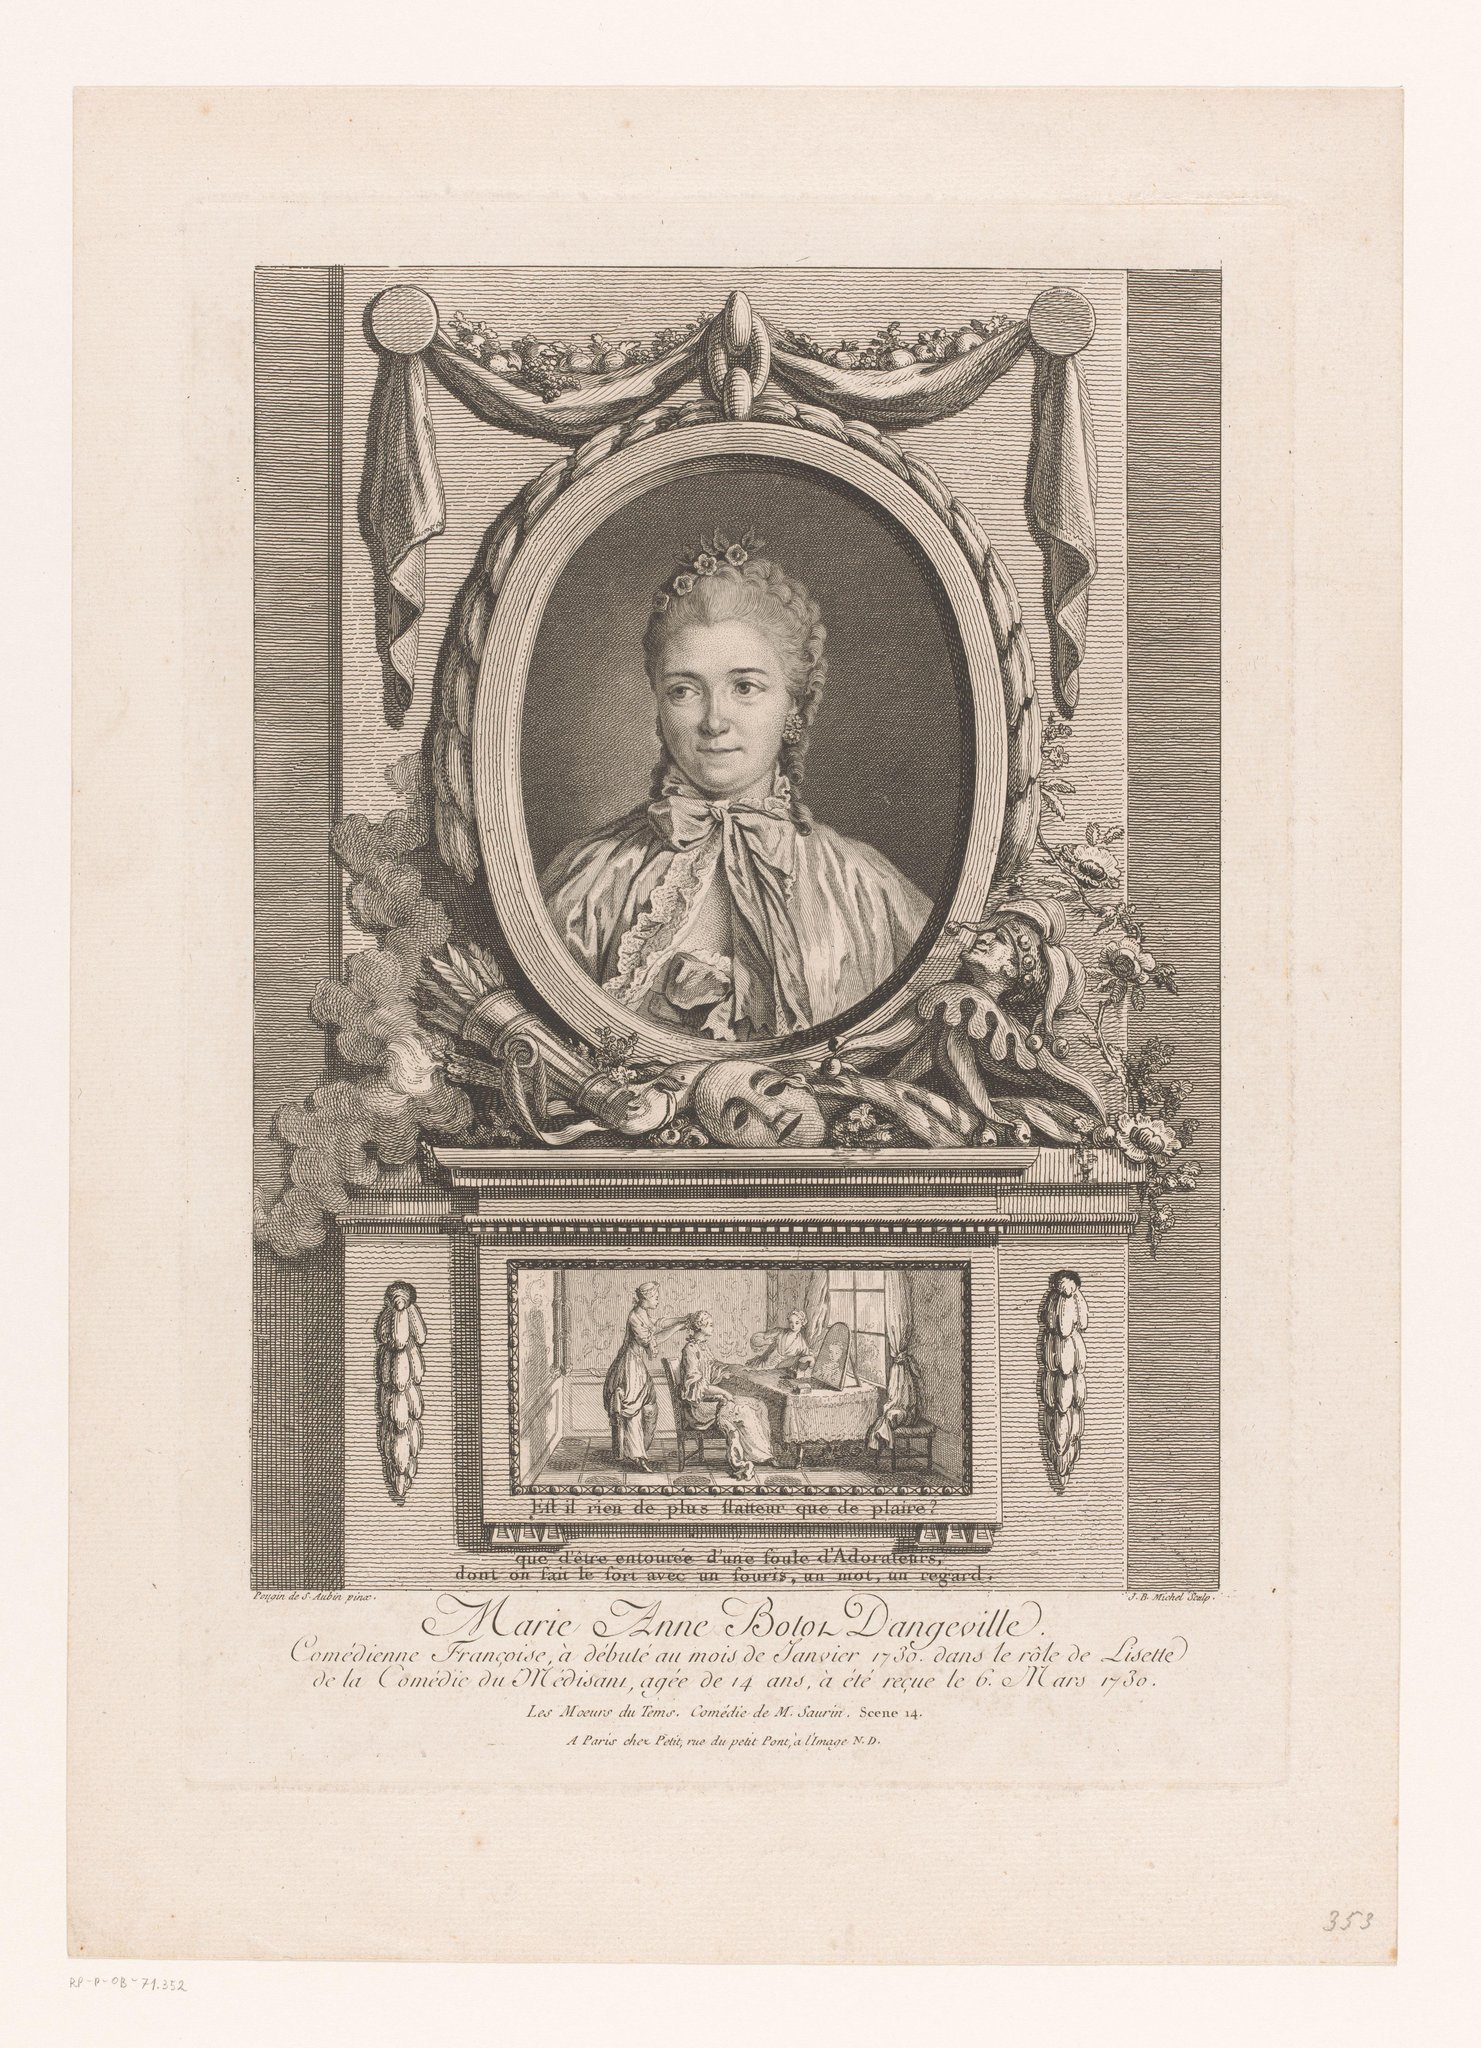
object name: print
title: Portret van Marie-Anne Boton Dangeville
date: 1758-1804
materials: paper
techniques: engraving, etching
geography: paris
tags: paris, historical persons - bb - woman, portrait of actor, actress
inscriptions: collector's mark: Lugt 2228